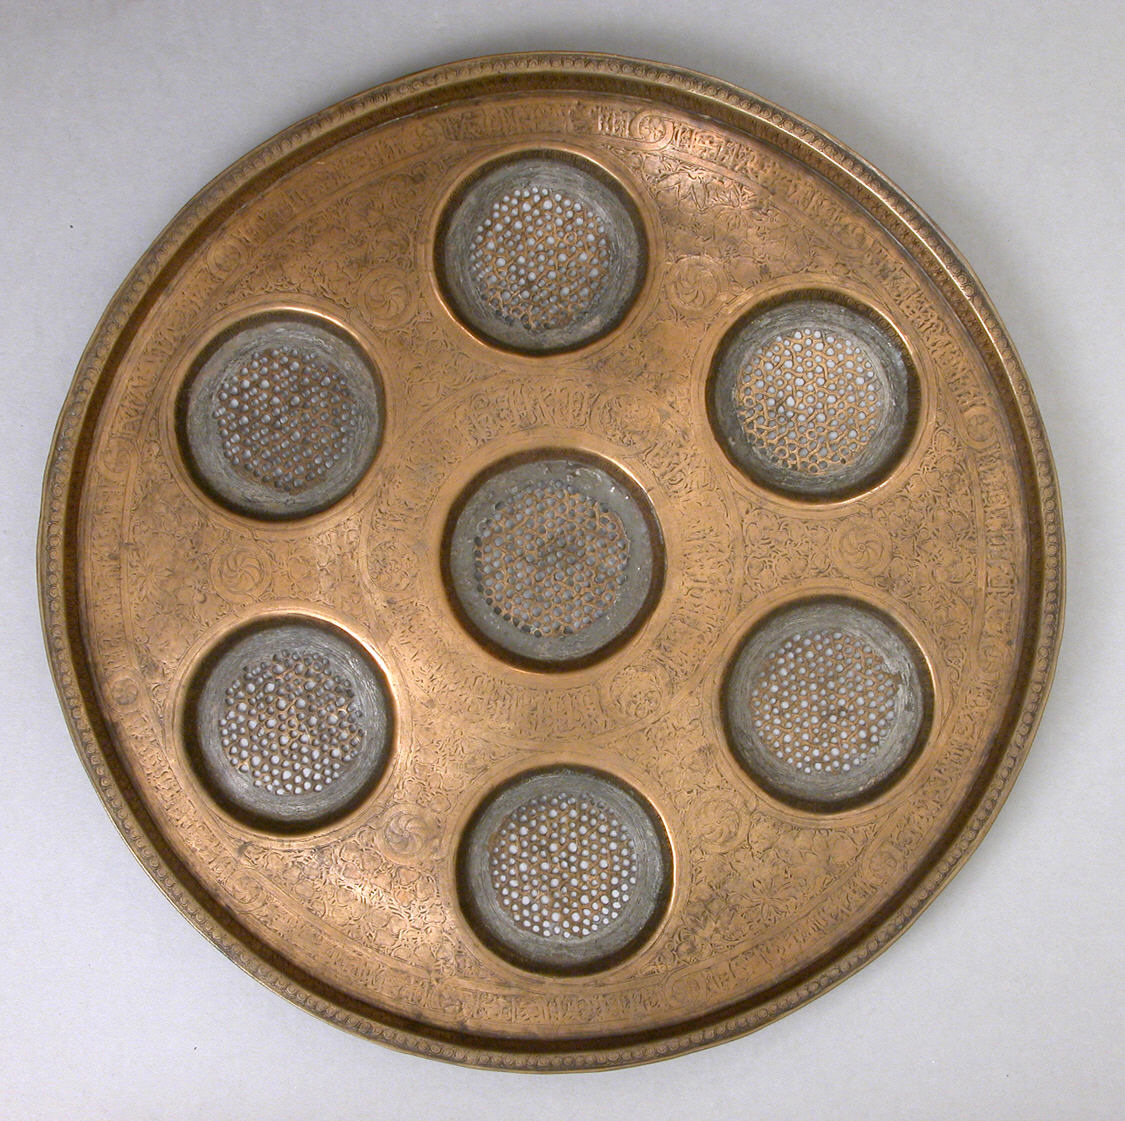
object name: tray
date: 1301-1400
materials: brass, silver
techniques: inlay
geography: egypt